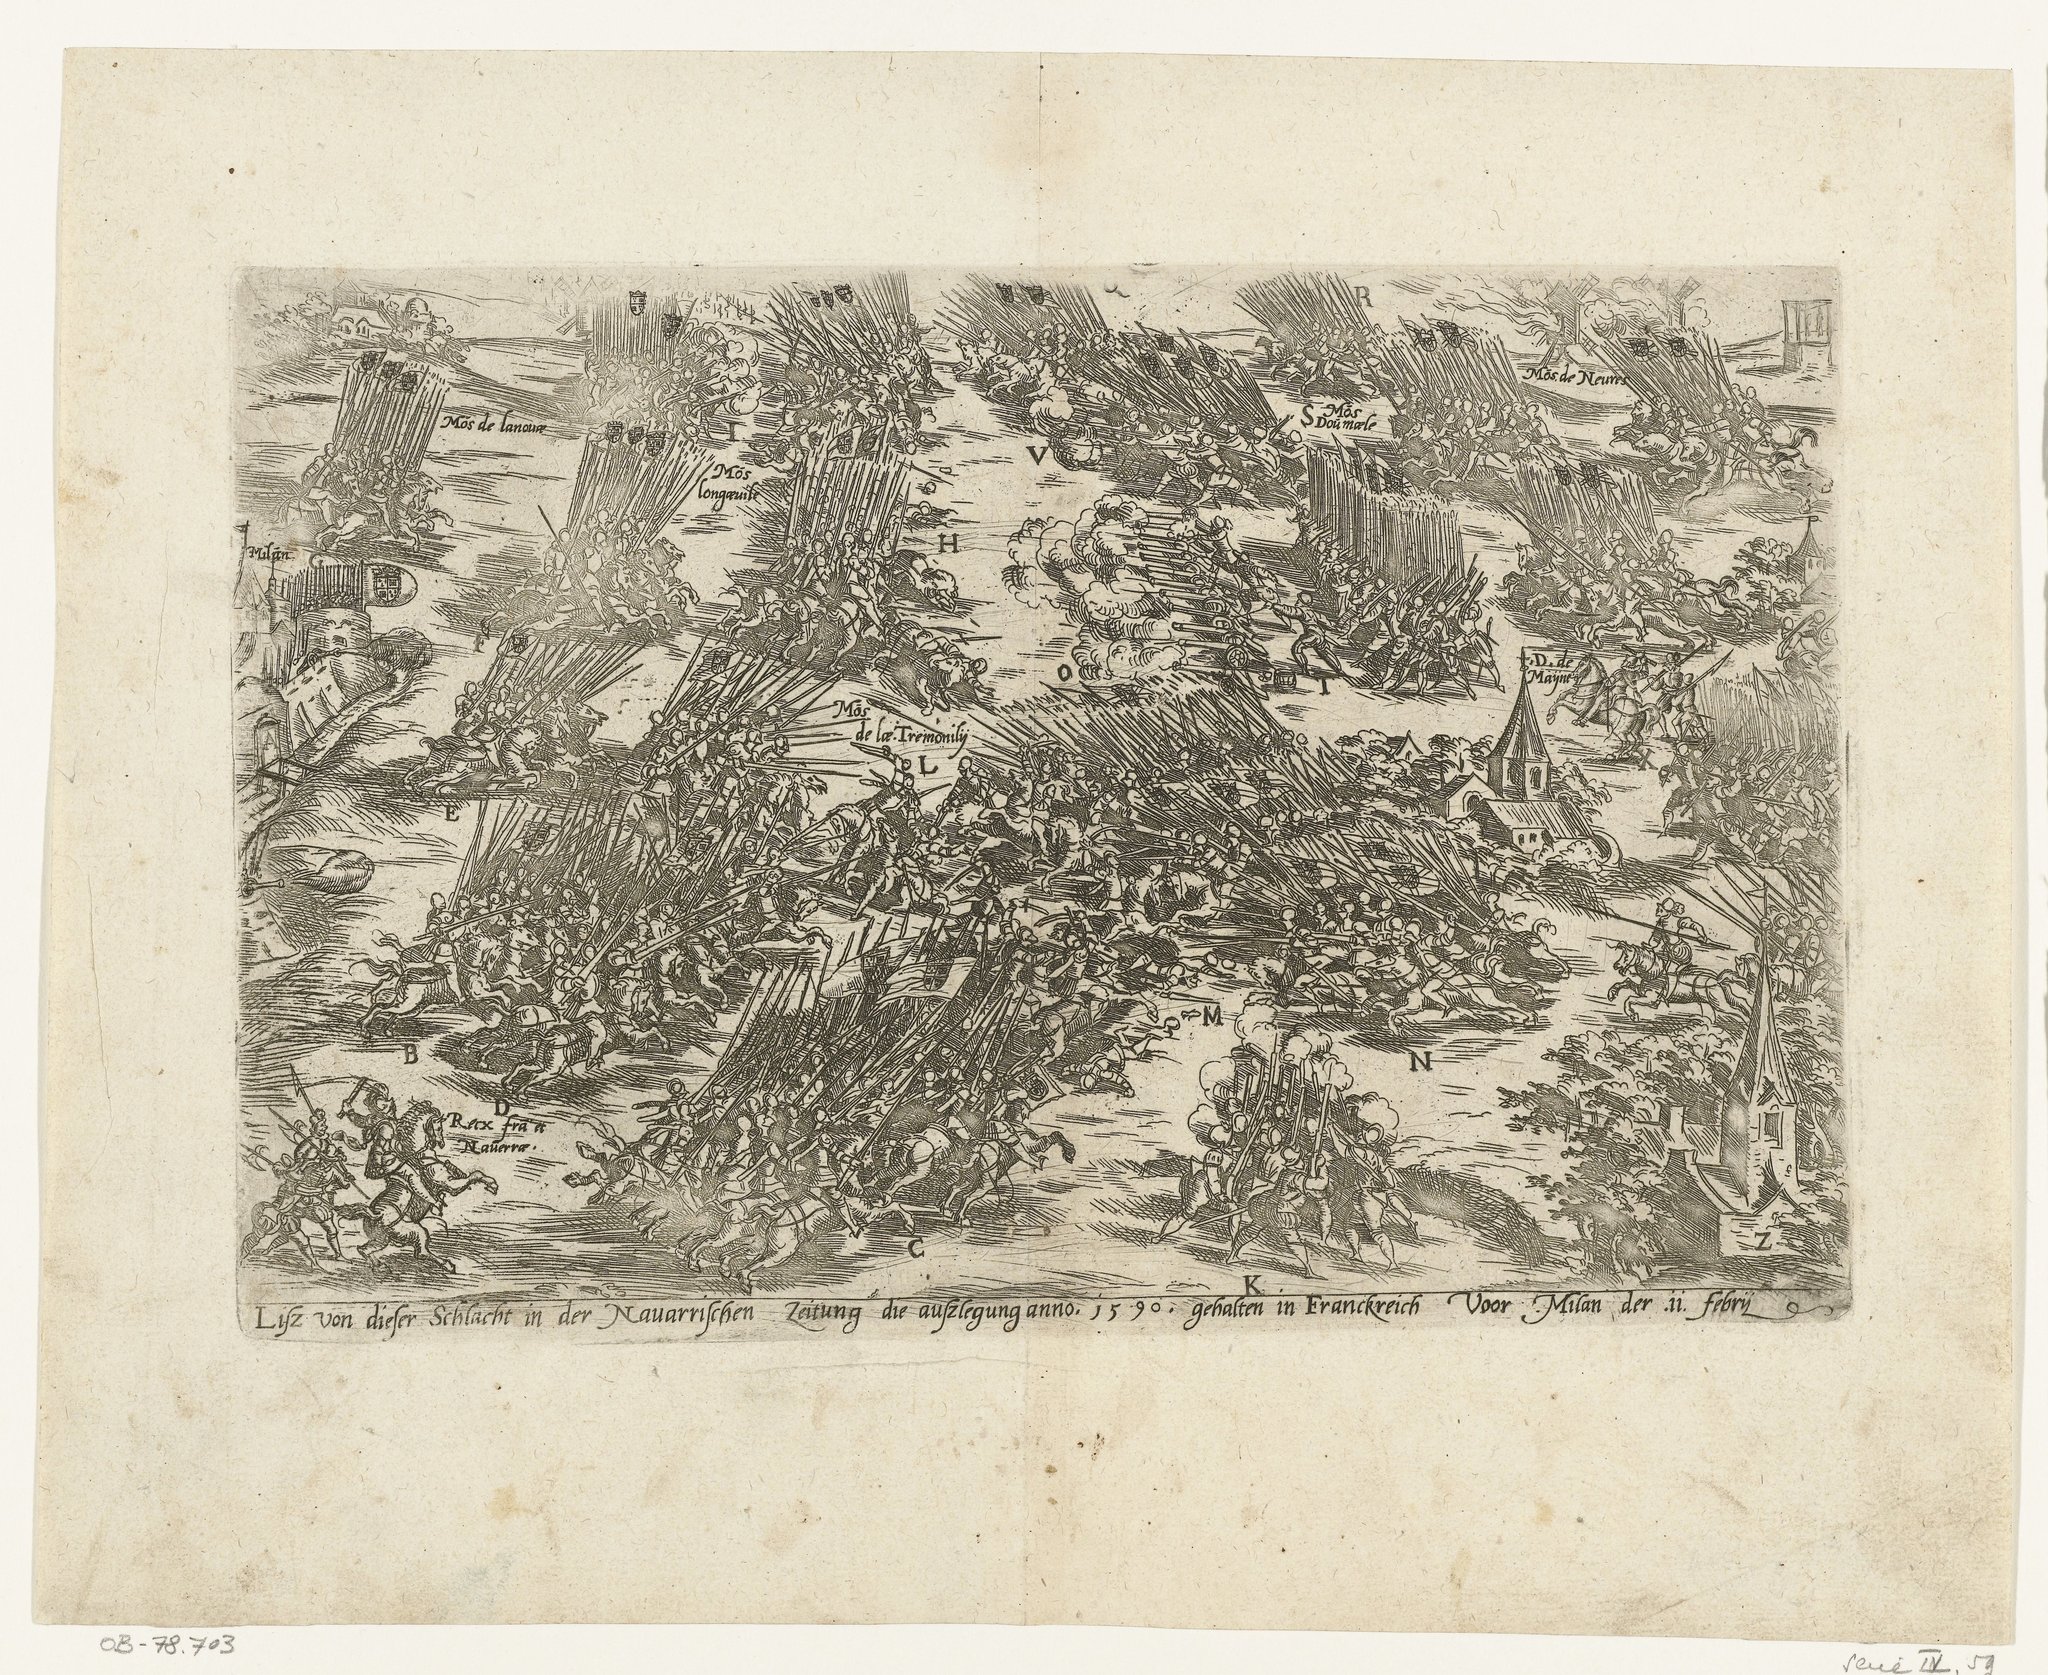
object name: print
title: Veldslag bij Dieppe, 1590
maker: Anonymous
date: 1590-1592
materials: paper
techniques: etching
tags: paris, hendrik iv (koning van frankrijk en navarra), battle, fighting in general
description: Veldslag bij Dieppe, 11 februari 1590. Linksonder de Franse koning Hendrik IV, te paard. De locatie van de veldslag wordt in het onderschrift aangeduid als: voor Milan. Met onderschrift van 1 regel in het Duits waarin voor details over deze slag wordt verwezen naar de Navarrischen Zeitung. Ongenummerd.